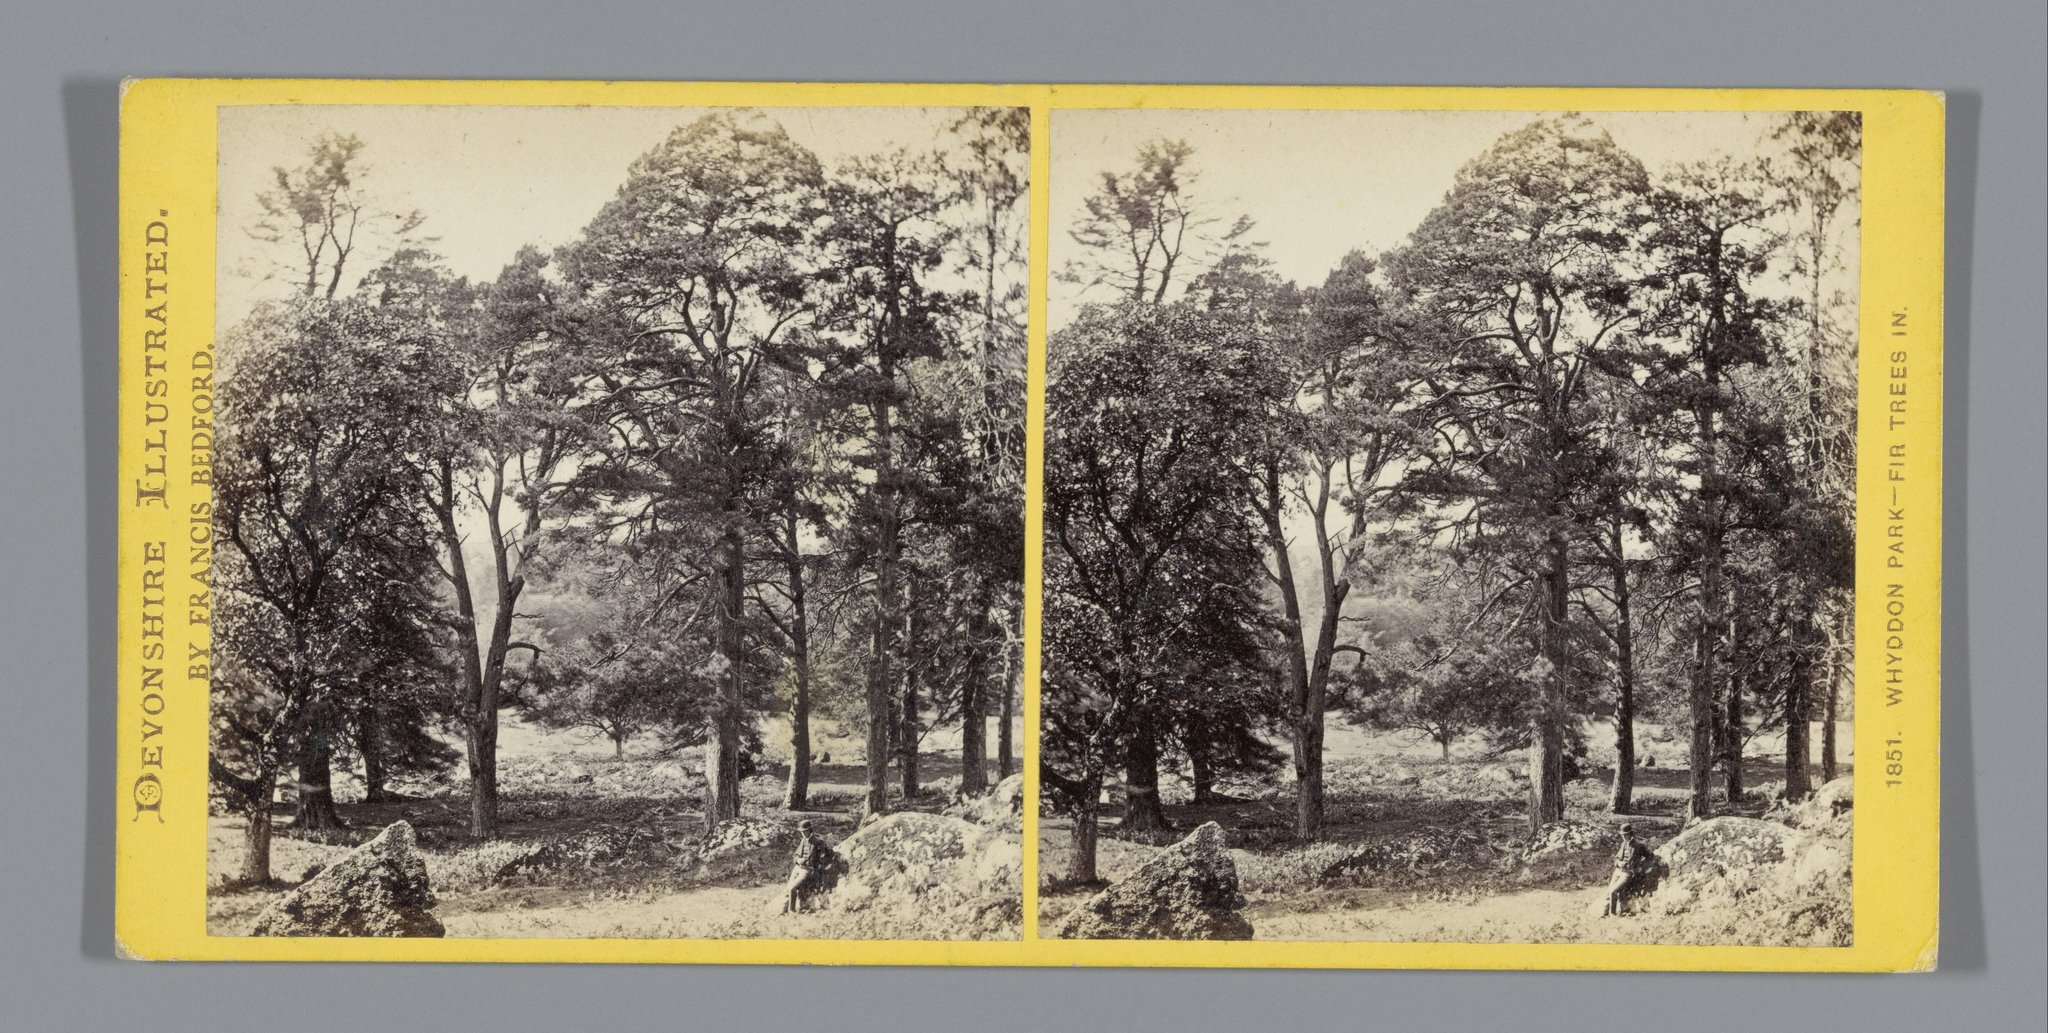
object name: stereograph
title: Sparren in Whiddon Park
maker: francis bedford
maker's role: print maker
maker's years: 1815-1894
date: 1850-1880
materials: cardboard, photographic support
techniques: albumen print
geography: devon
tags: park, trees: fir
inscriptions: inscription: ‘Devonshire Illustrated. by Francis Bedford.’, number: ‘1851.’